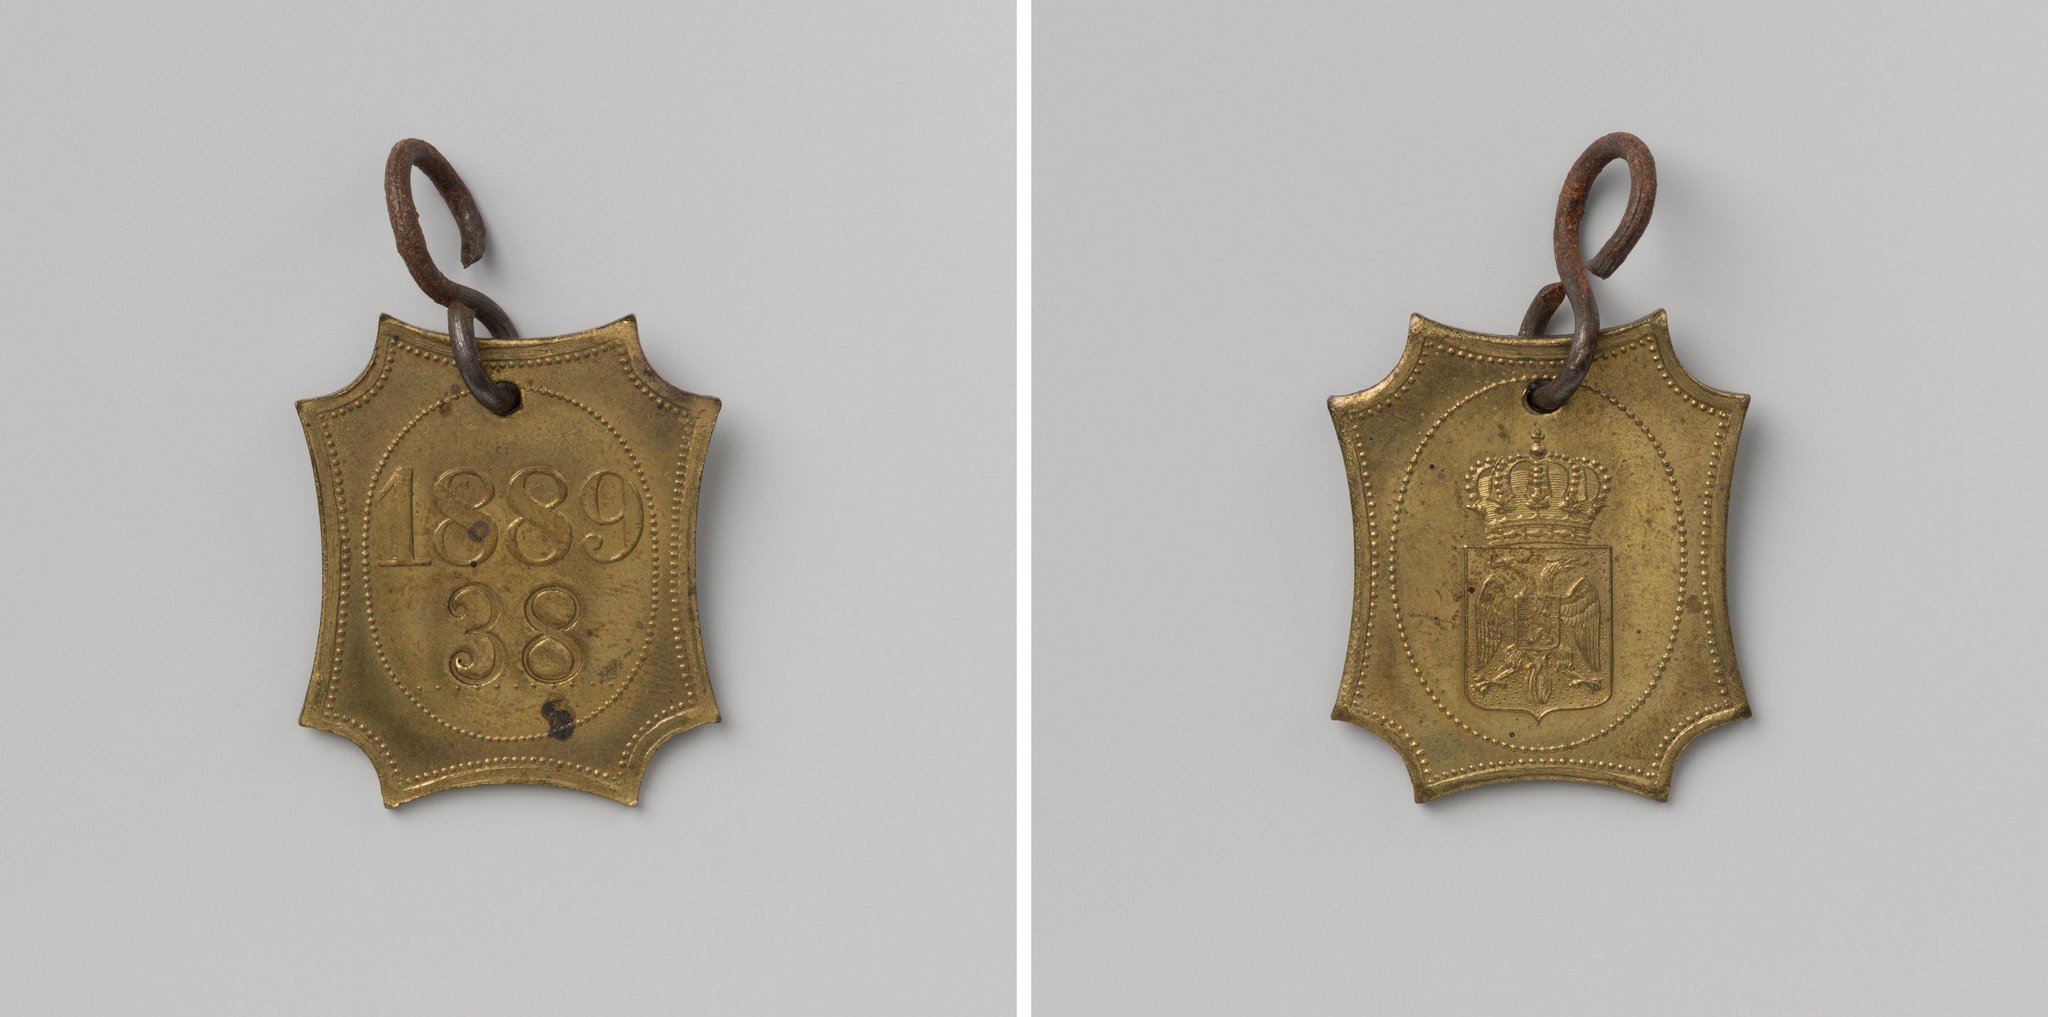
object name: tax token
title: Loodje met no. 38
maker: Anonymous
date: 1889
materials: brass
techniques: striking